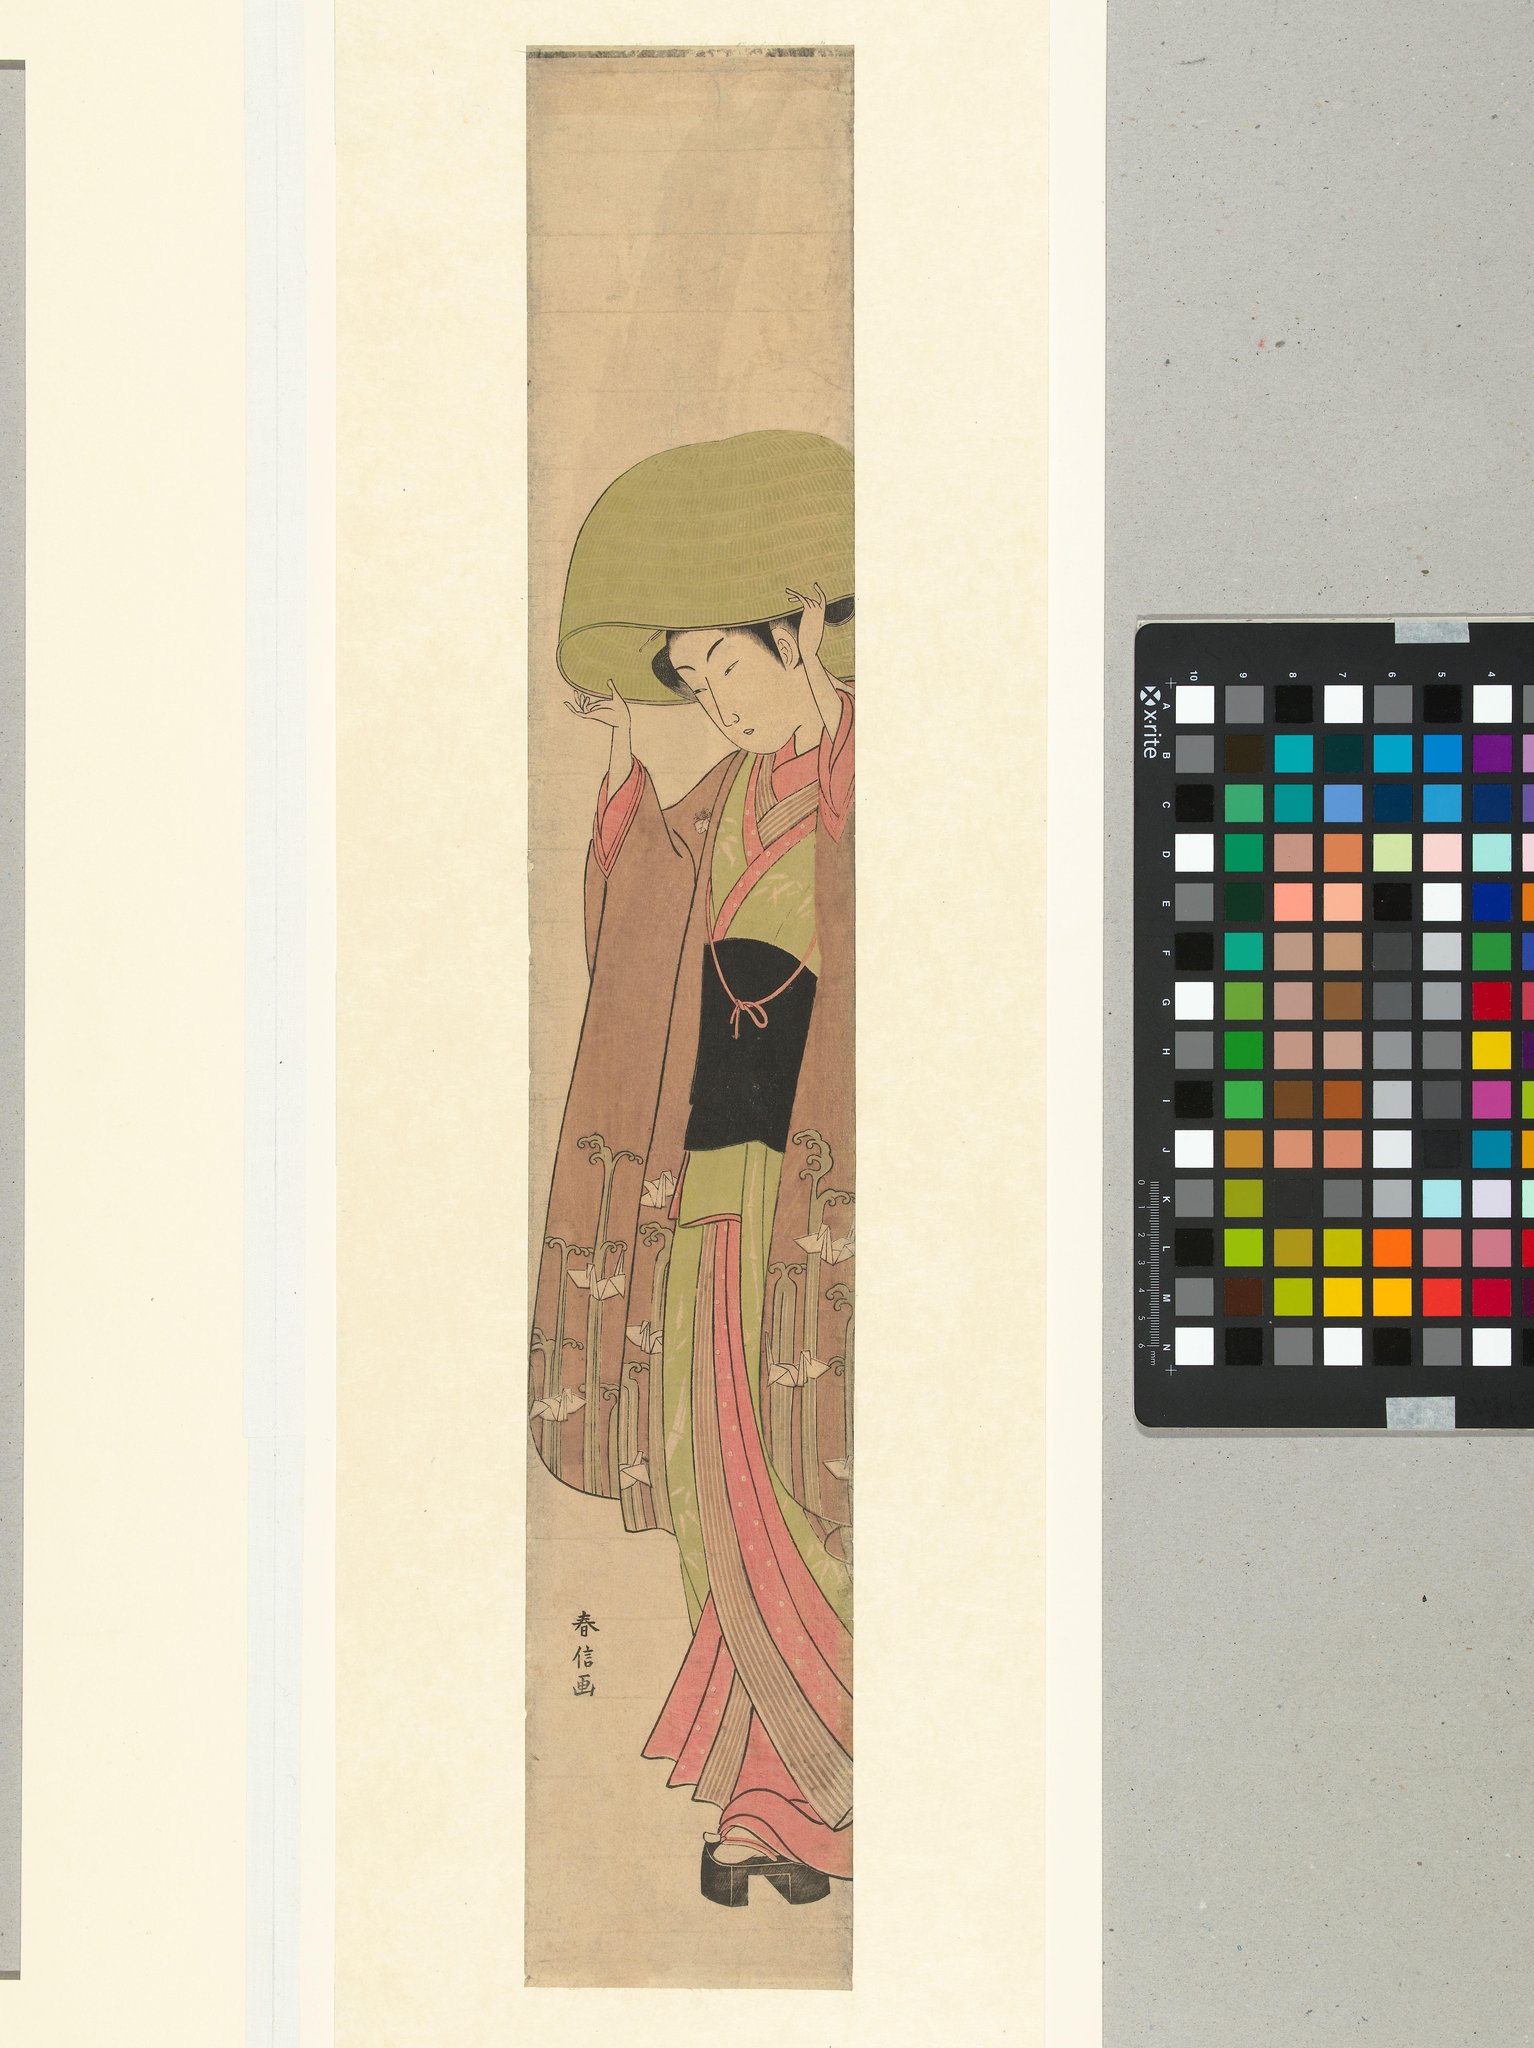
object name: print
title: Rieten hoed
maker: suzuki harunobu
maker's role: print maker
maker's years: 1725-1770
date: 1765-1770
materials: paper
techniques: woodcut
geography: japan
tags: adolescent, young woman, maiden, head-gear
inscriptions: collector's mark: Lugt 2228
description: Meisje in kimono met patroon van origami kraanvogels en gestileerde golven, een rieten hoed opzettend.